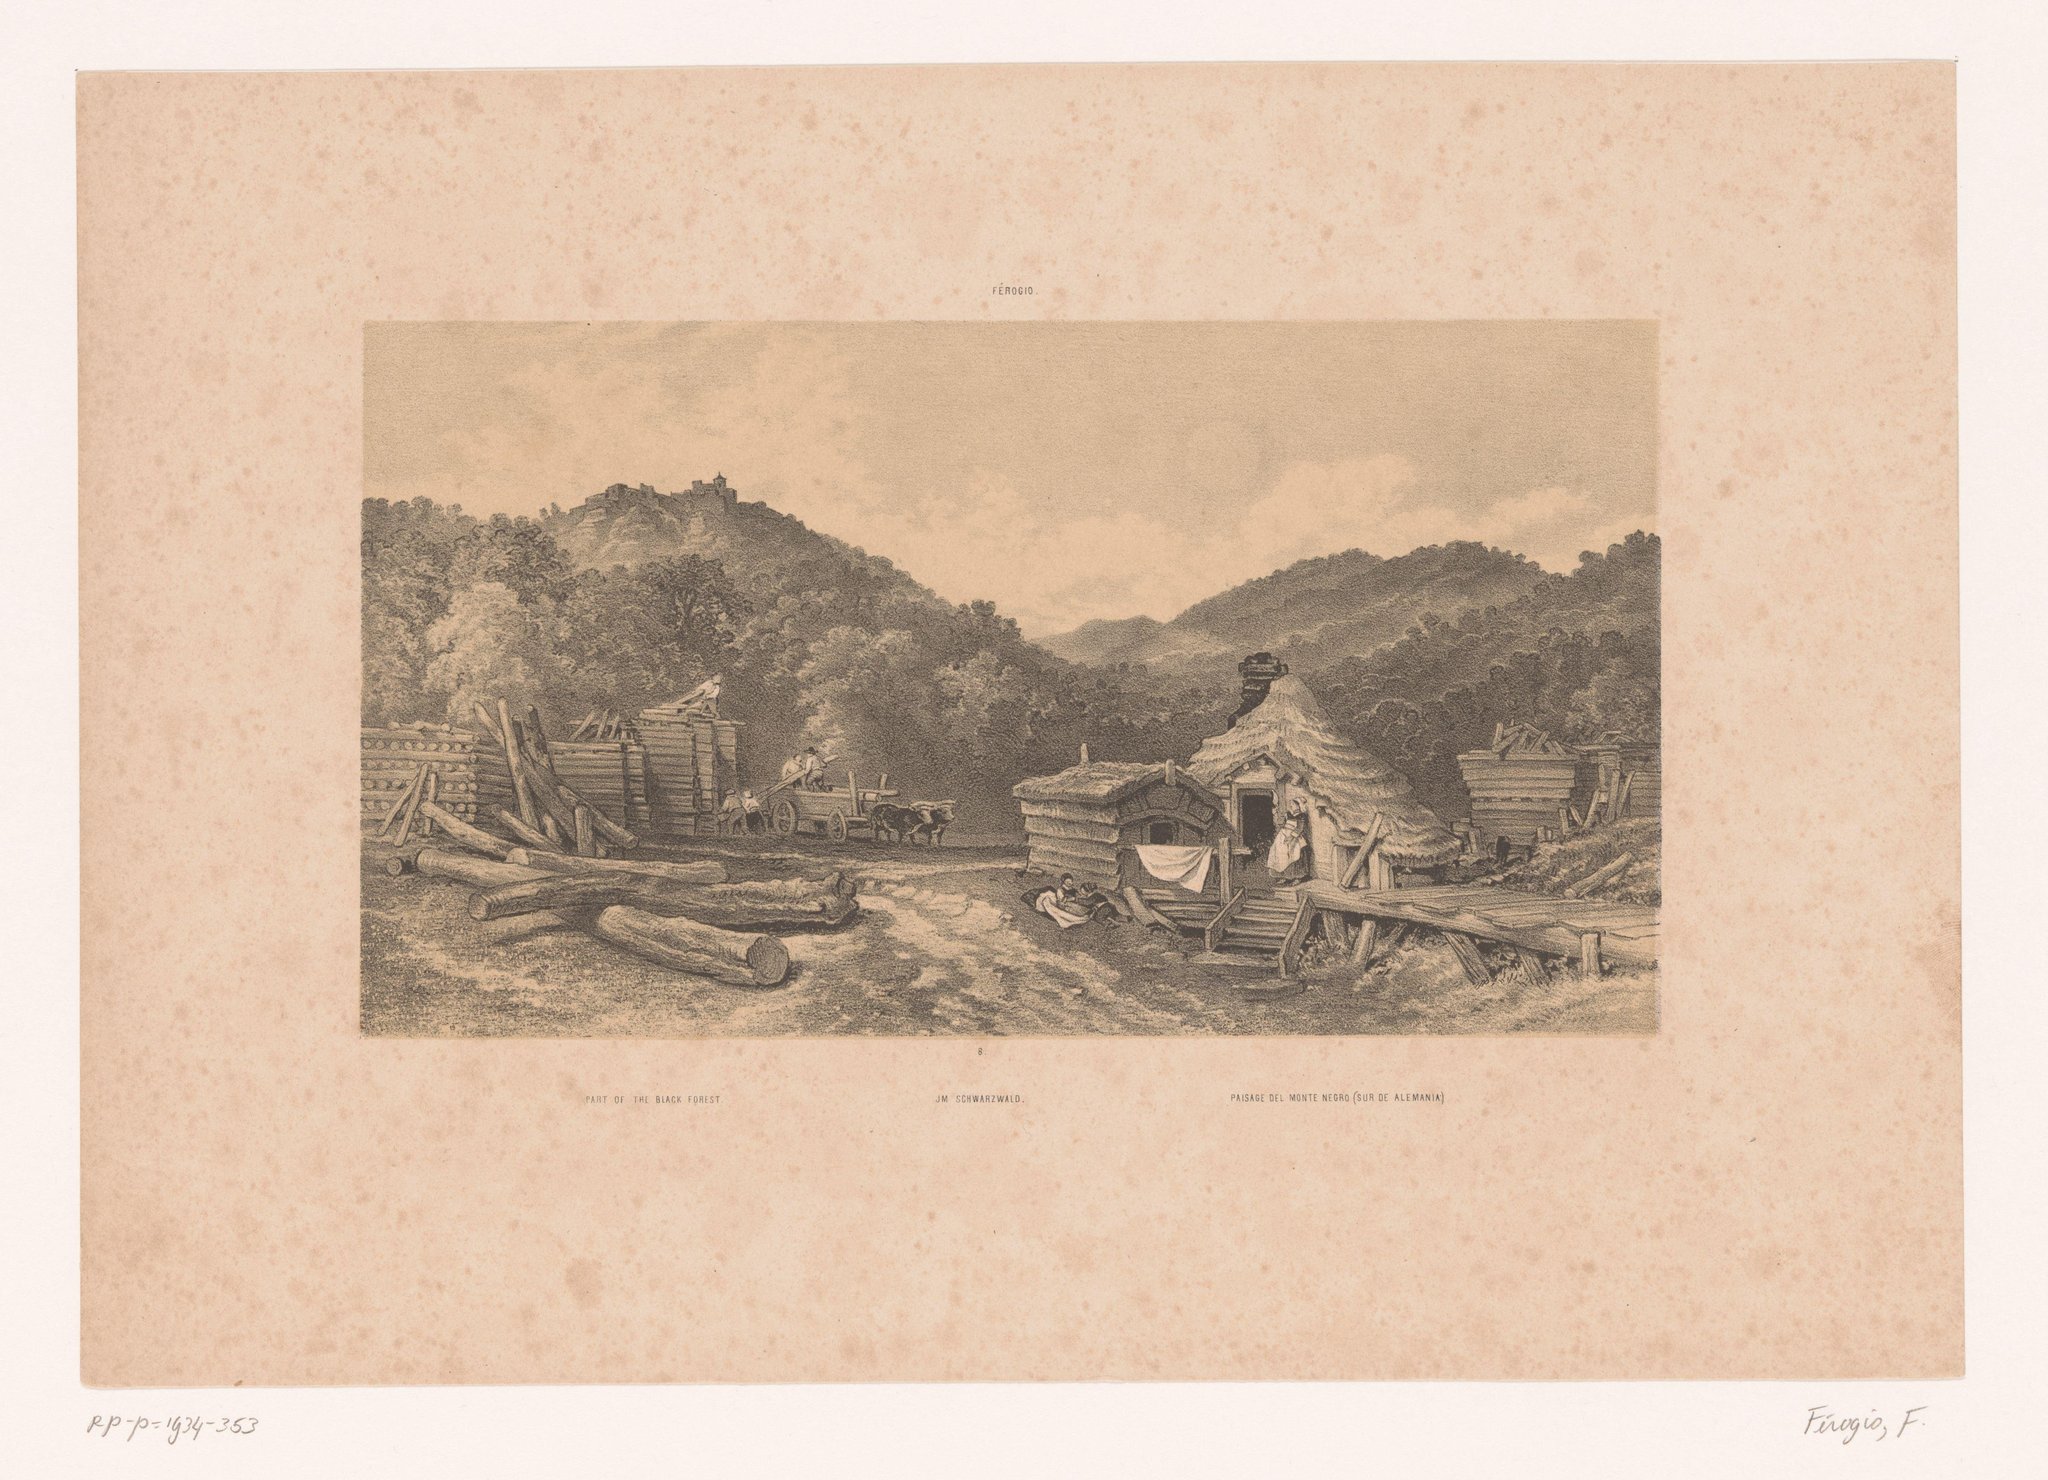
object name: print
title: Houthakkers in het Zwarte Woud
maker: fortuné férogio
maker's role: print maker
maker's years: 1805-1888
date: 1829-1875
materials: paper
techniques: tone lithography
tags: woodcutting, woodcutter ~ forestry, hut, cabin, lodge